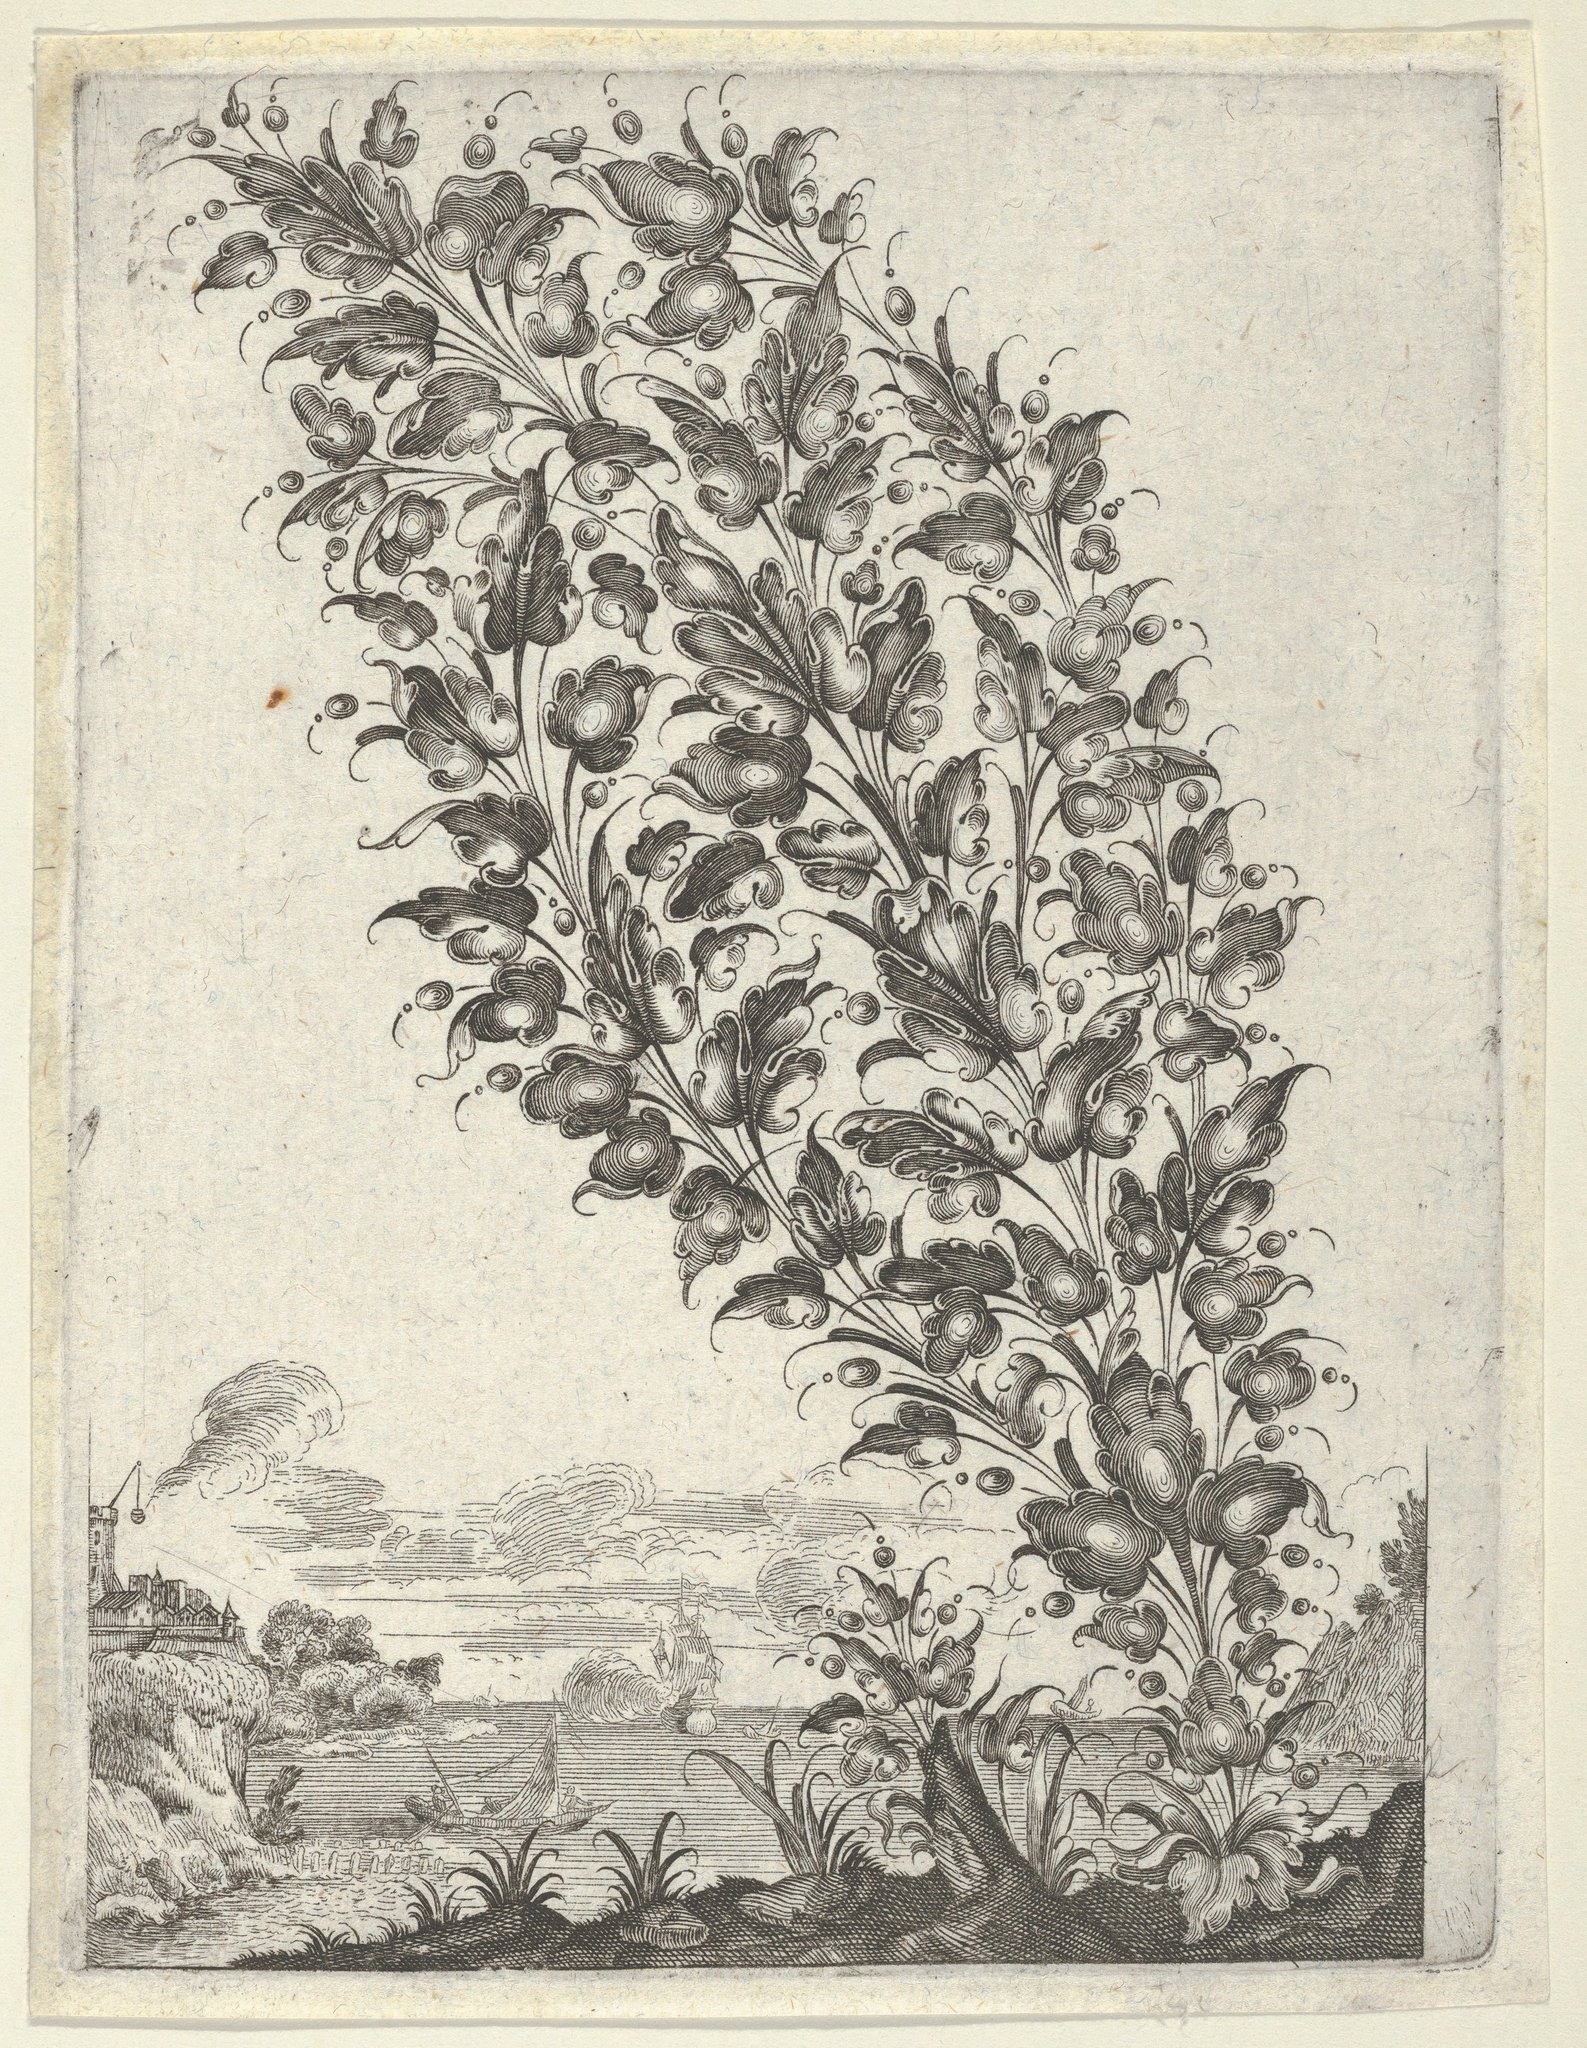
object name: print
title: Goldsmith's Bouquet, from "Newes Lauberbuechlein"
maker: peter aubry ii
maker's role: artist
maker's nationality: german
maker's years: 1610-1666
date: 1628-1666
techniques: engraving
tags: flowers,leaves